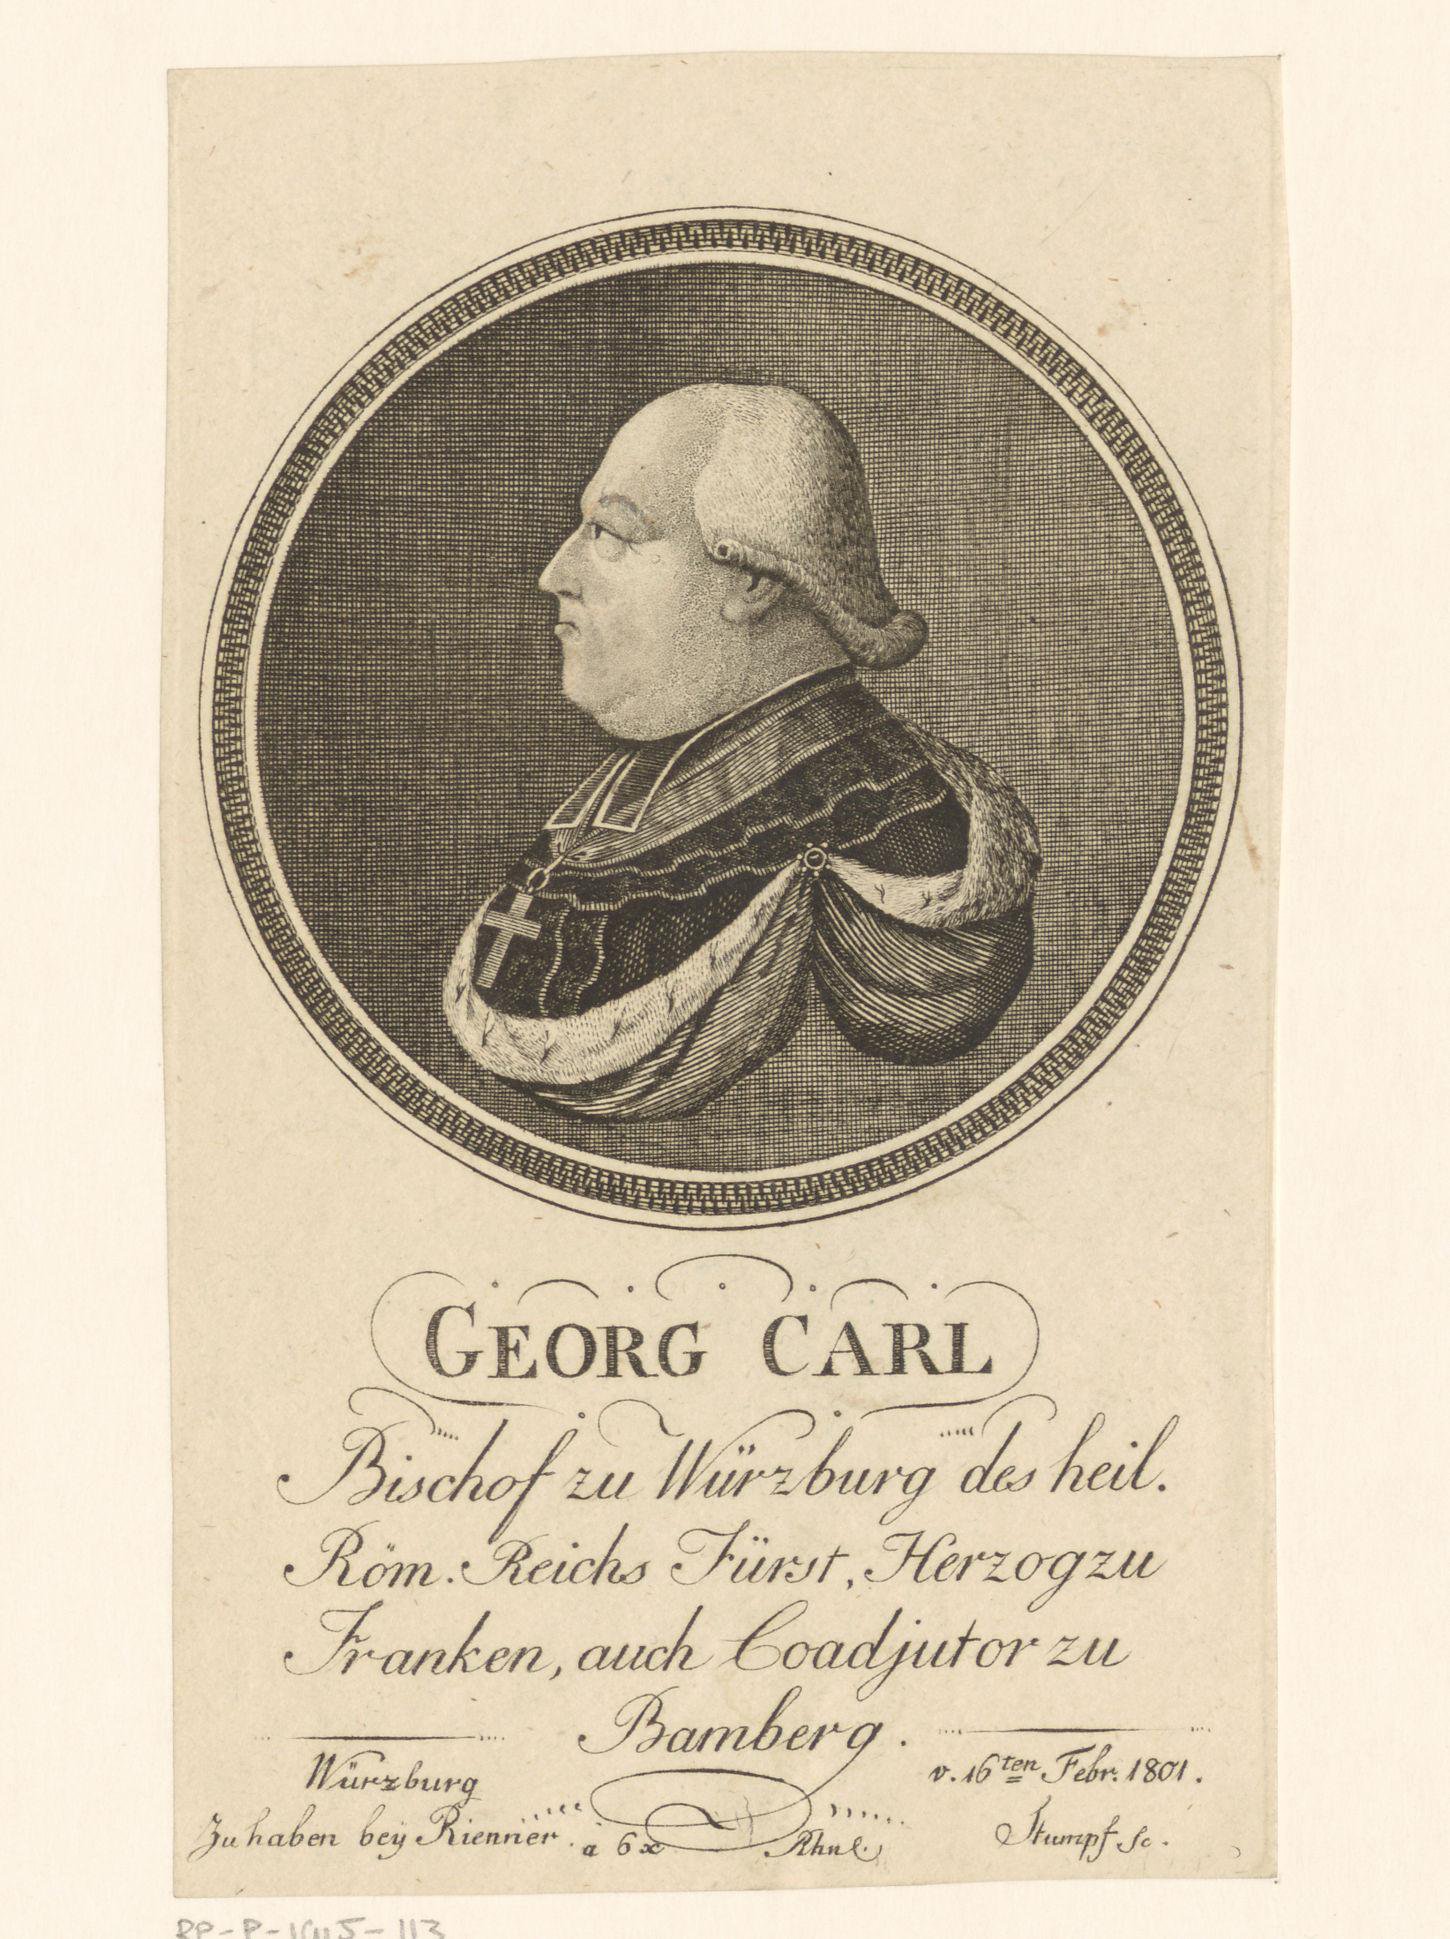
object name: print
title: Portret van Georg Karl, Freiherr von Fechenbach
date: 1801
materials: paper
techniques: etching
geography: würzburg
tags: historical persons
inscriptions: collector's mark: Lugt 2228